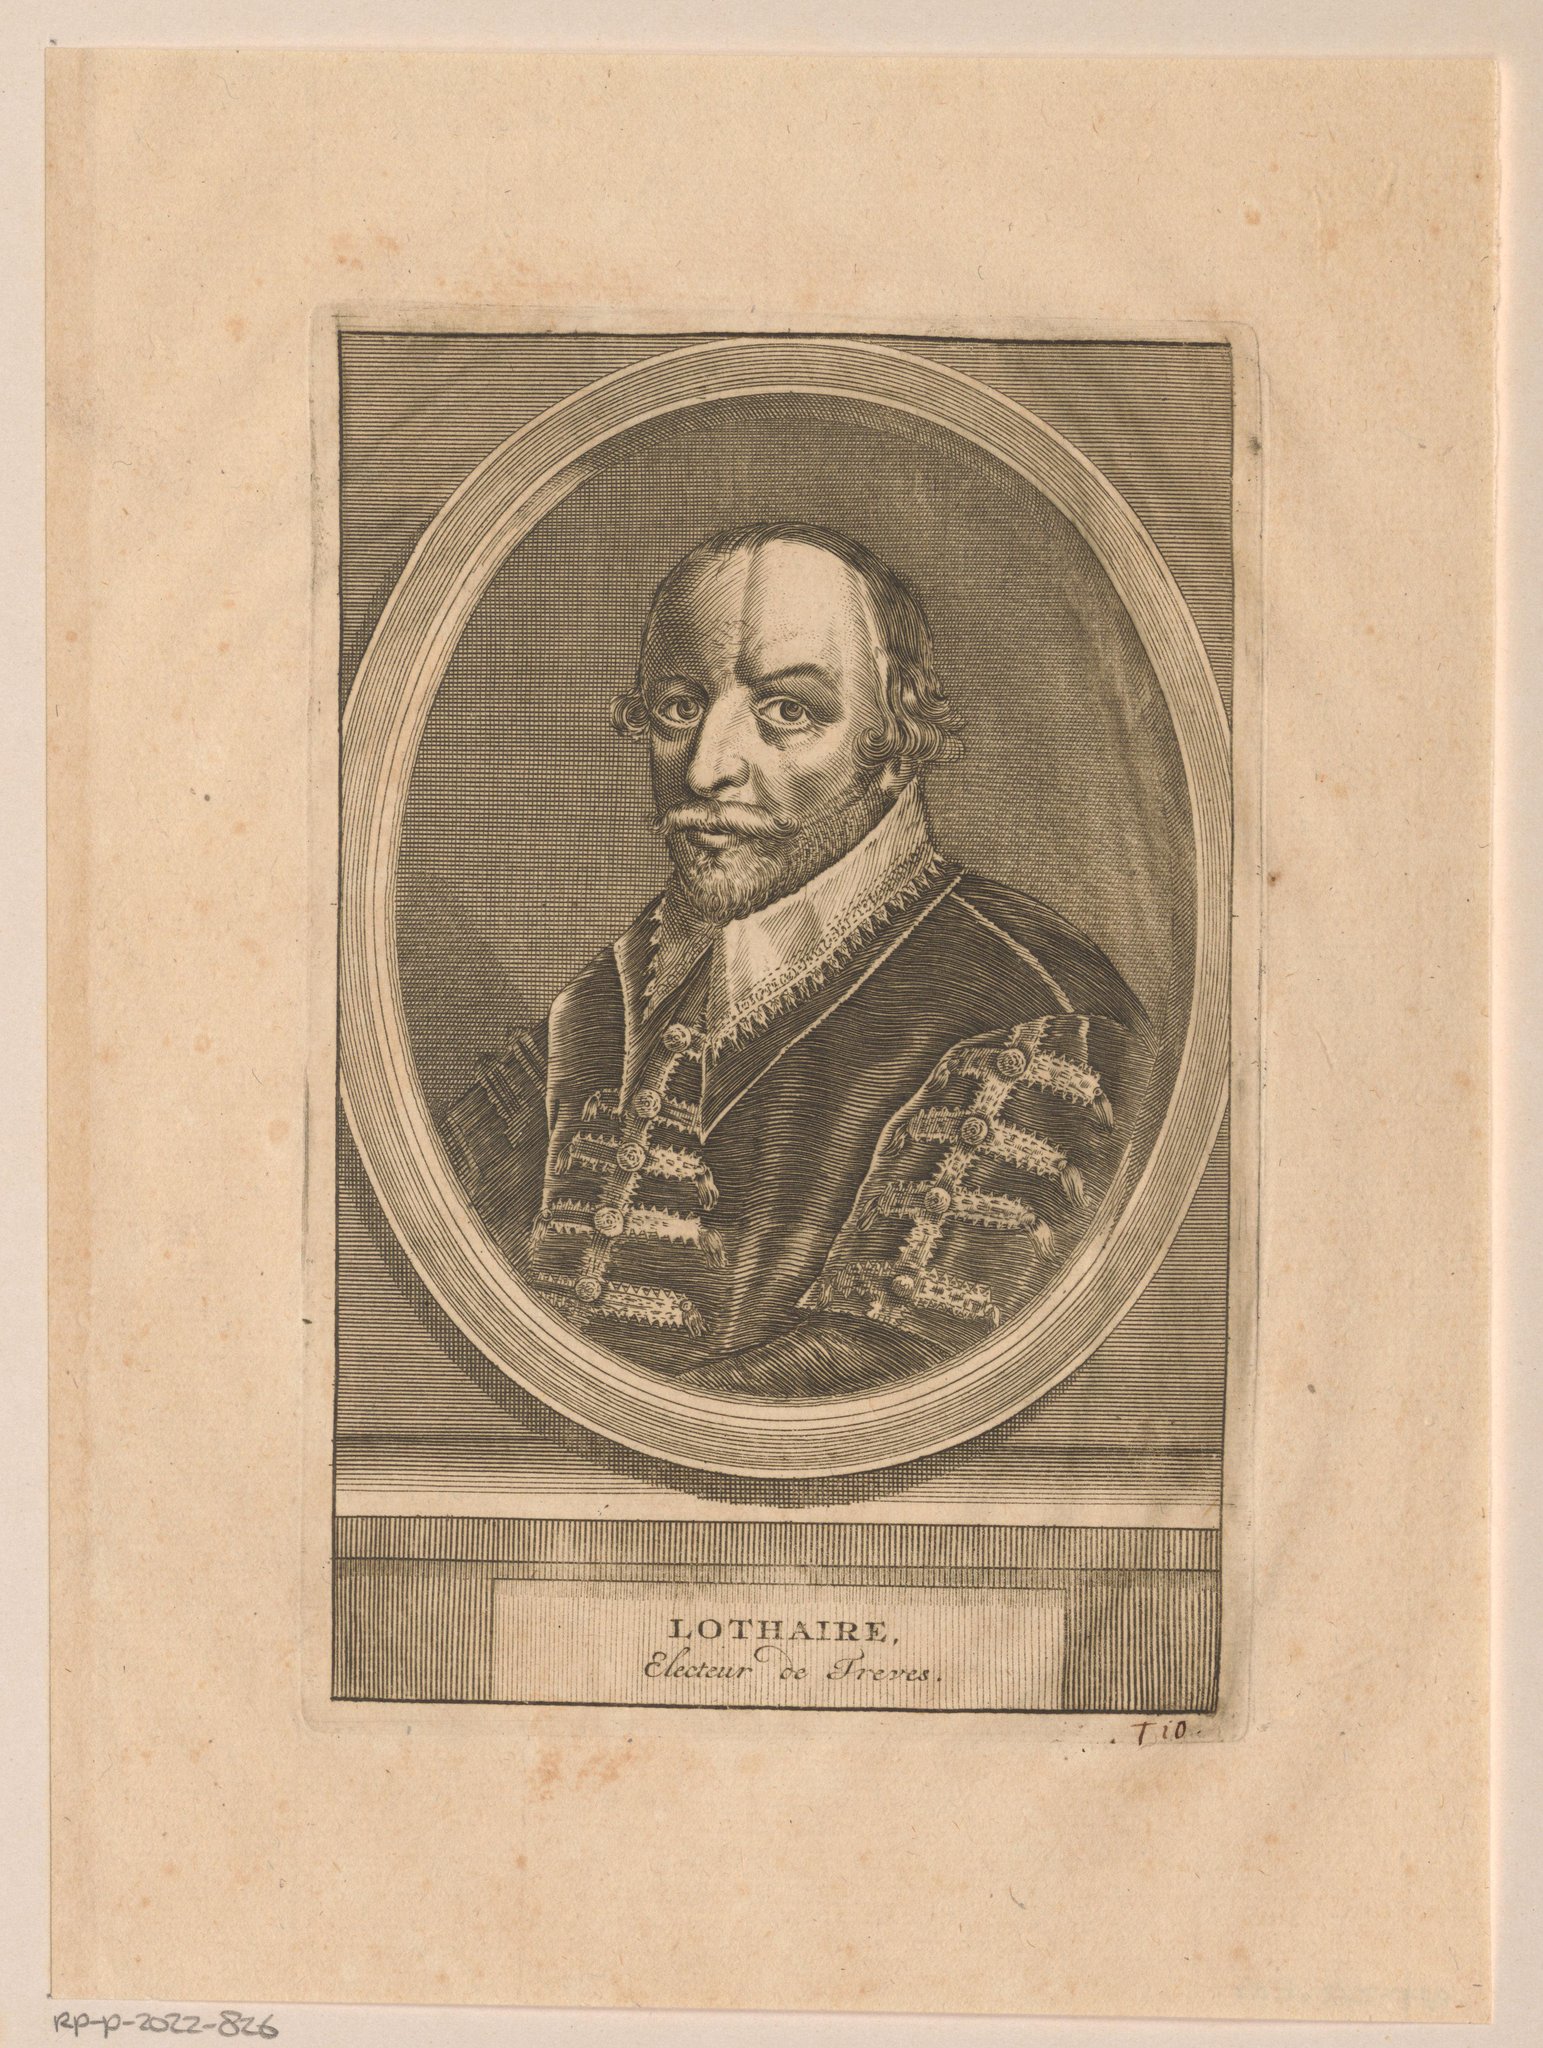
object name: print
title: Portret van Lothar Friedrich Metternich-Burscheid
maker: Anonymous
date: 1600-1800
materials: paper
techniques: engraving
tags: historical persons